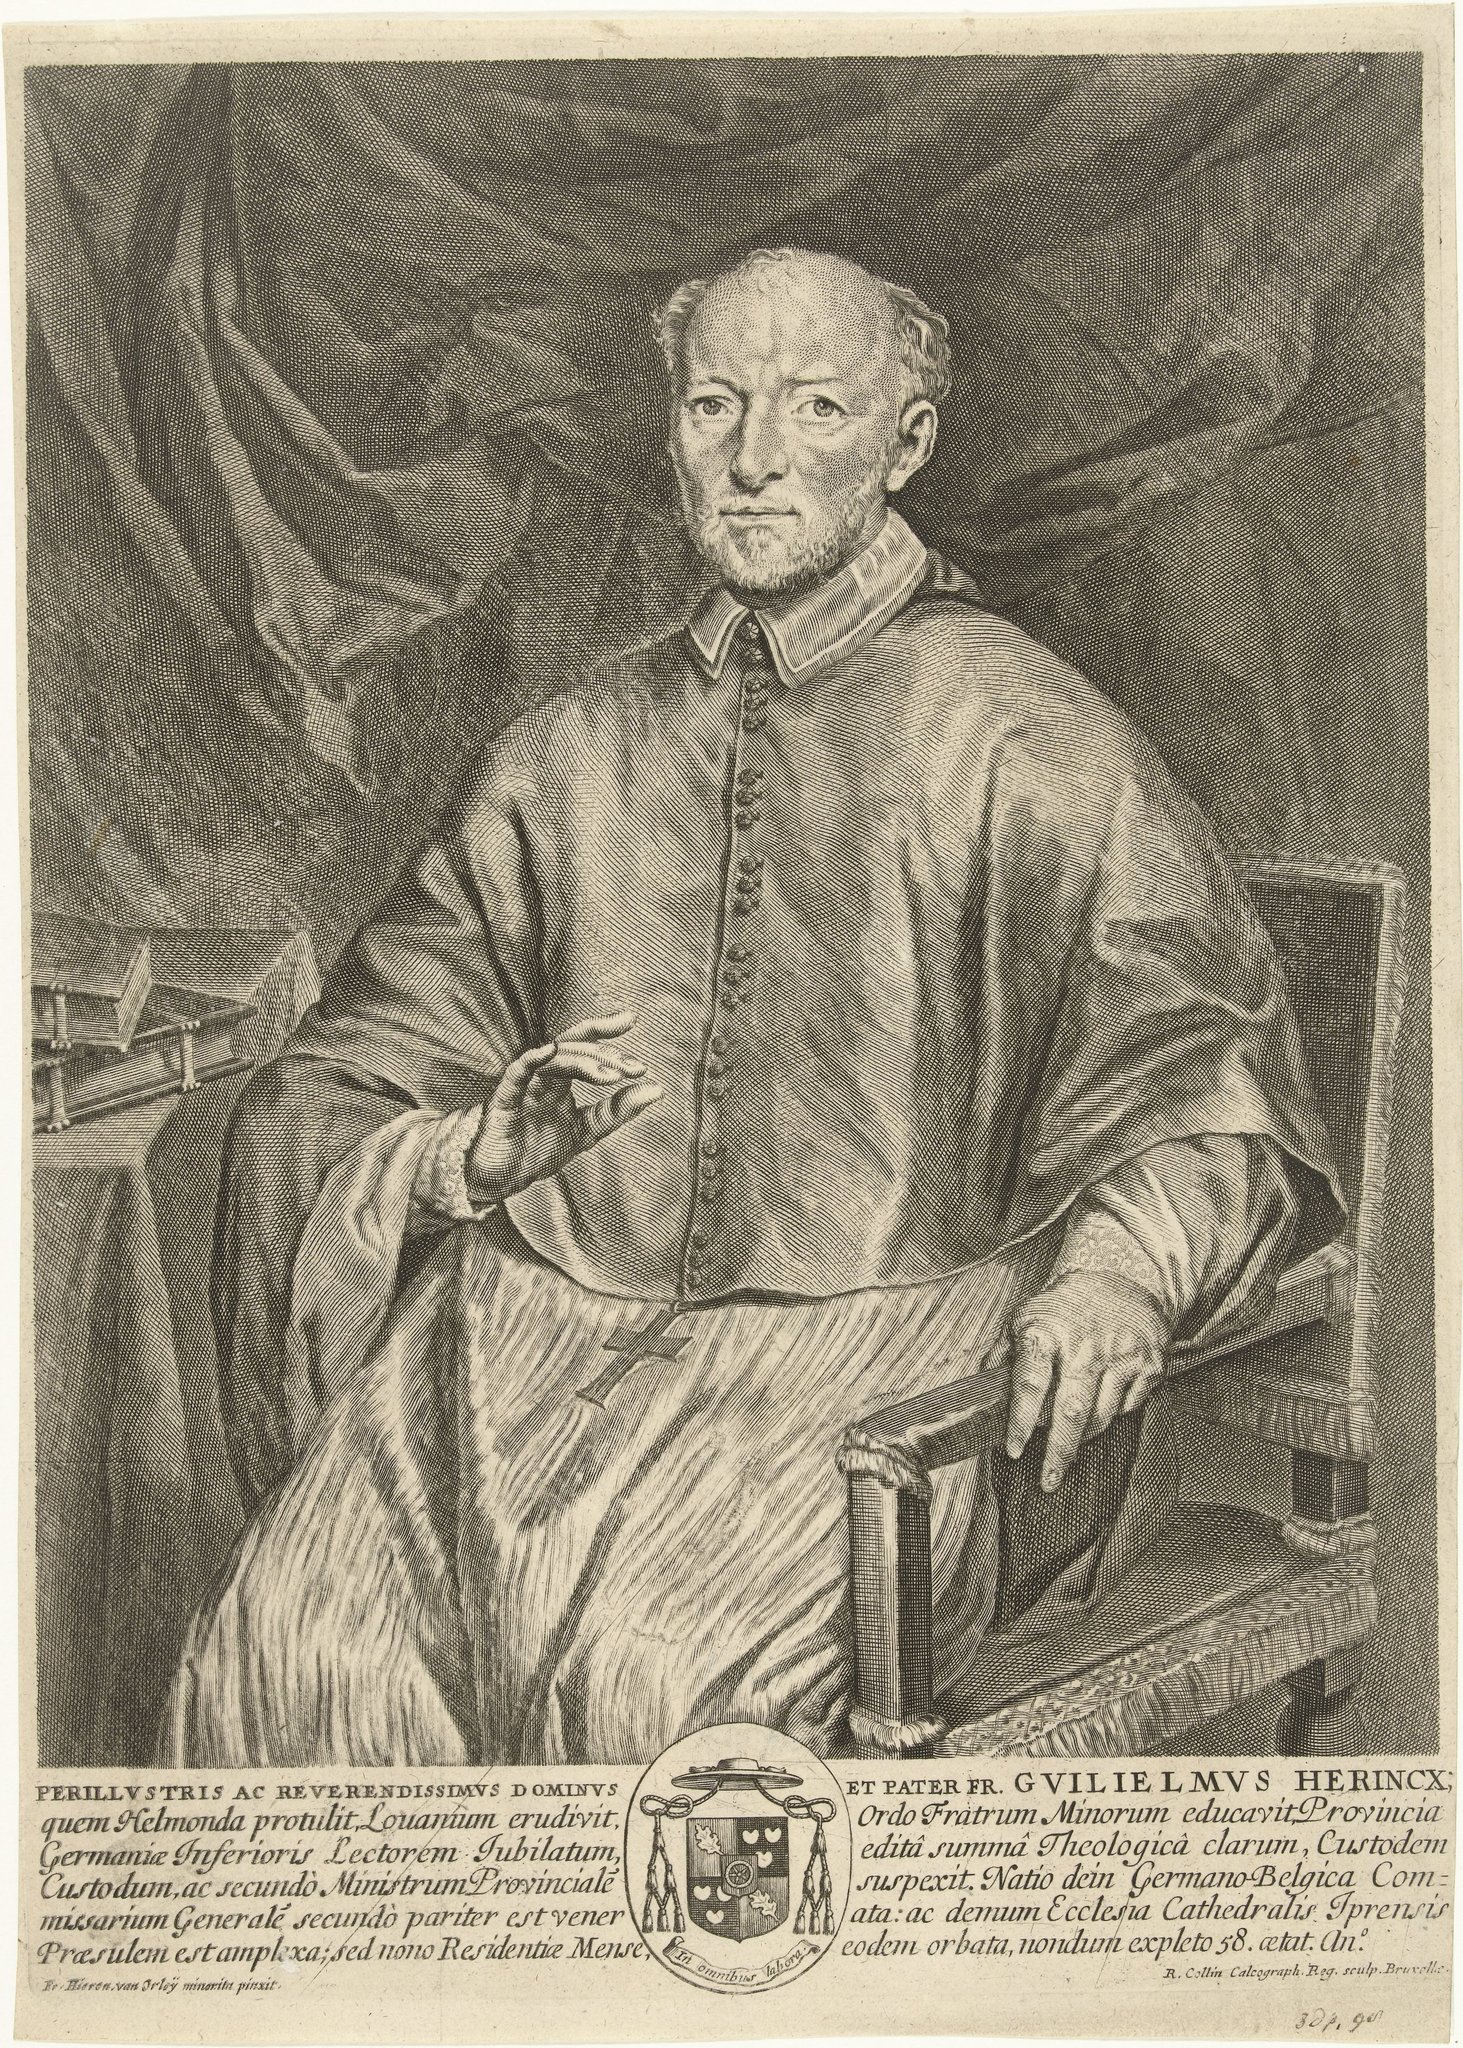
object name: print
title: Portret van Willem Herincx, bisschop van Yperen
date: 1678-1694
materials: paper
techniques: engraving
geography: brussels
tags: willem herincx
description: Portret van Willem Herincx, bisschop van Yperen zittend in een stoel. Onder het portret een Latijnse tekst over zijn leven. Vlak voor zijn dood werd Herincx voorgedragen als kardinaal, in het midden zijn familiewapen met kardinaalshoed.